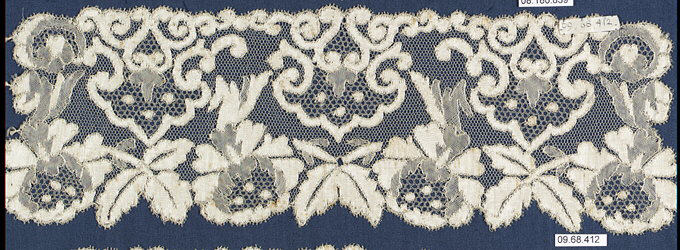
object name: bobbin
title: Silk bobbin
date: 1801-1900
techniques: lace